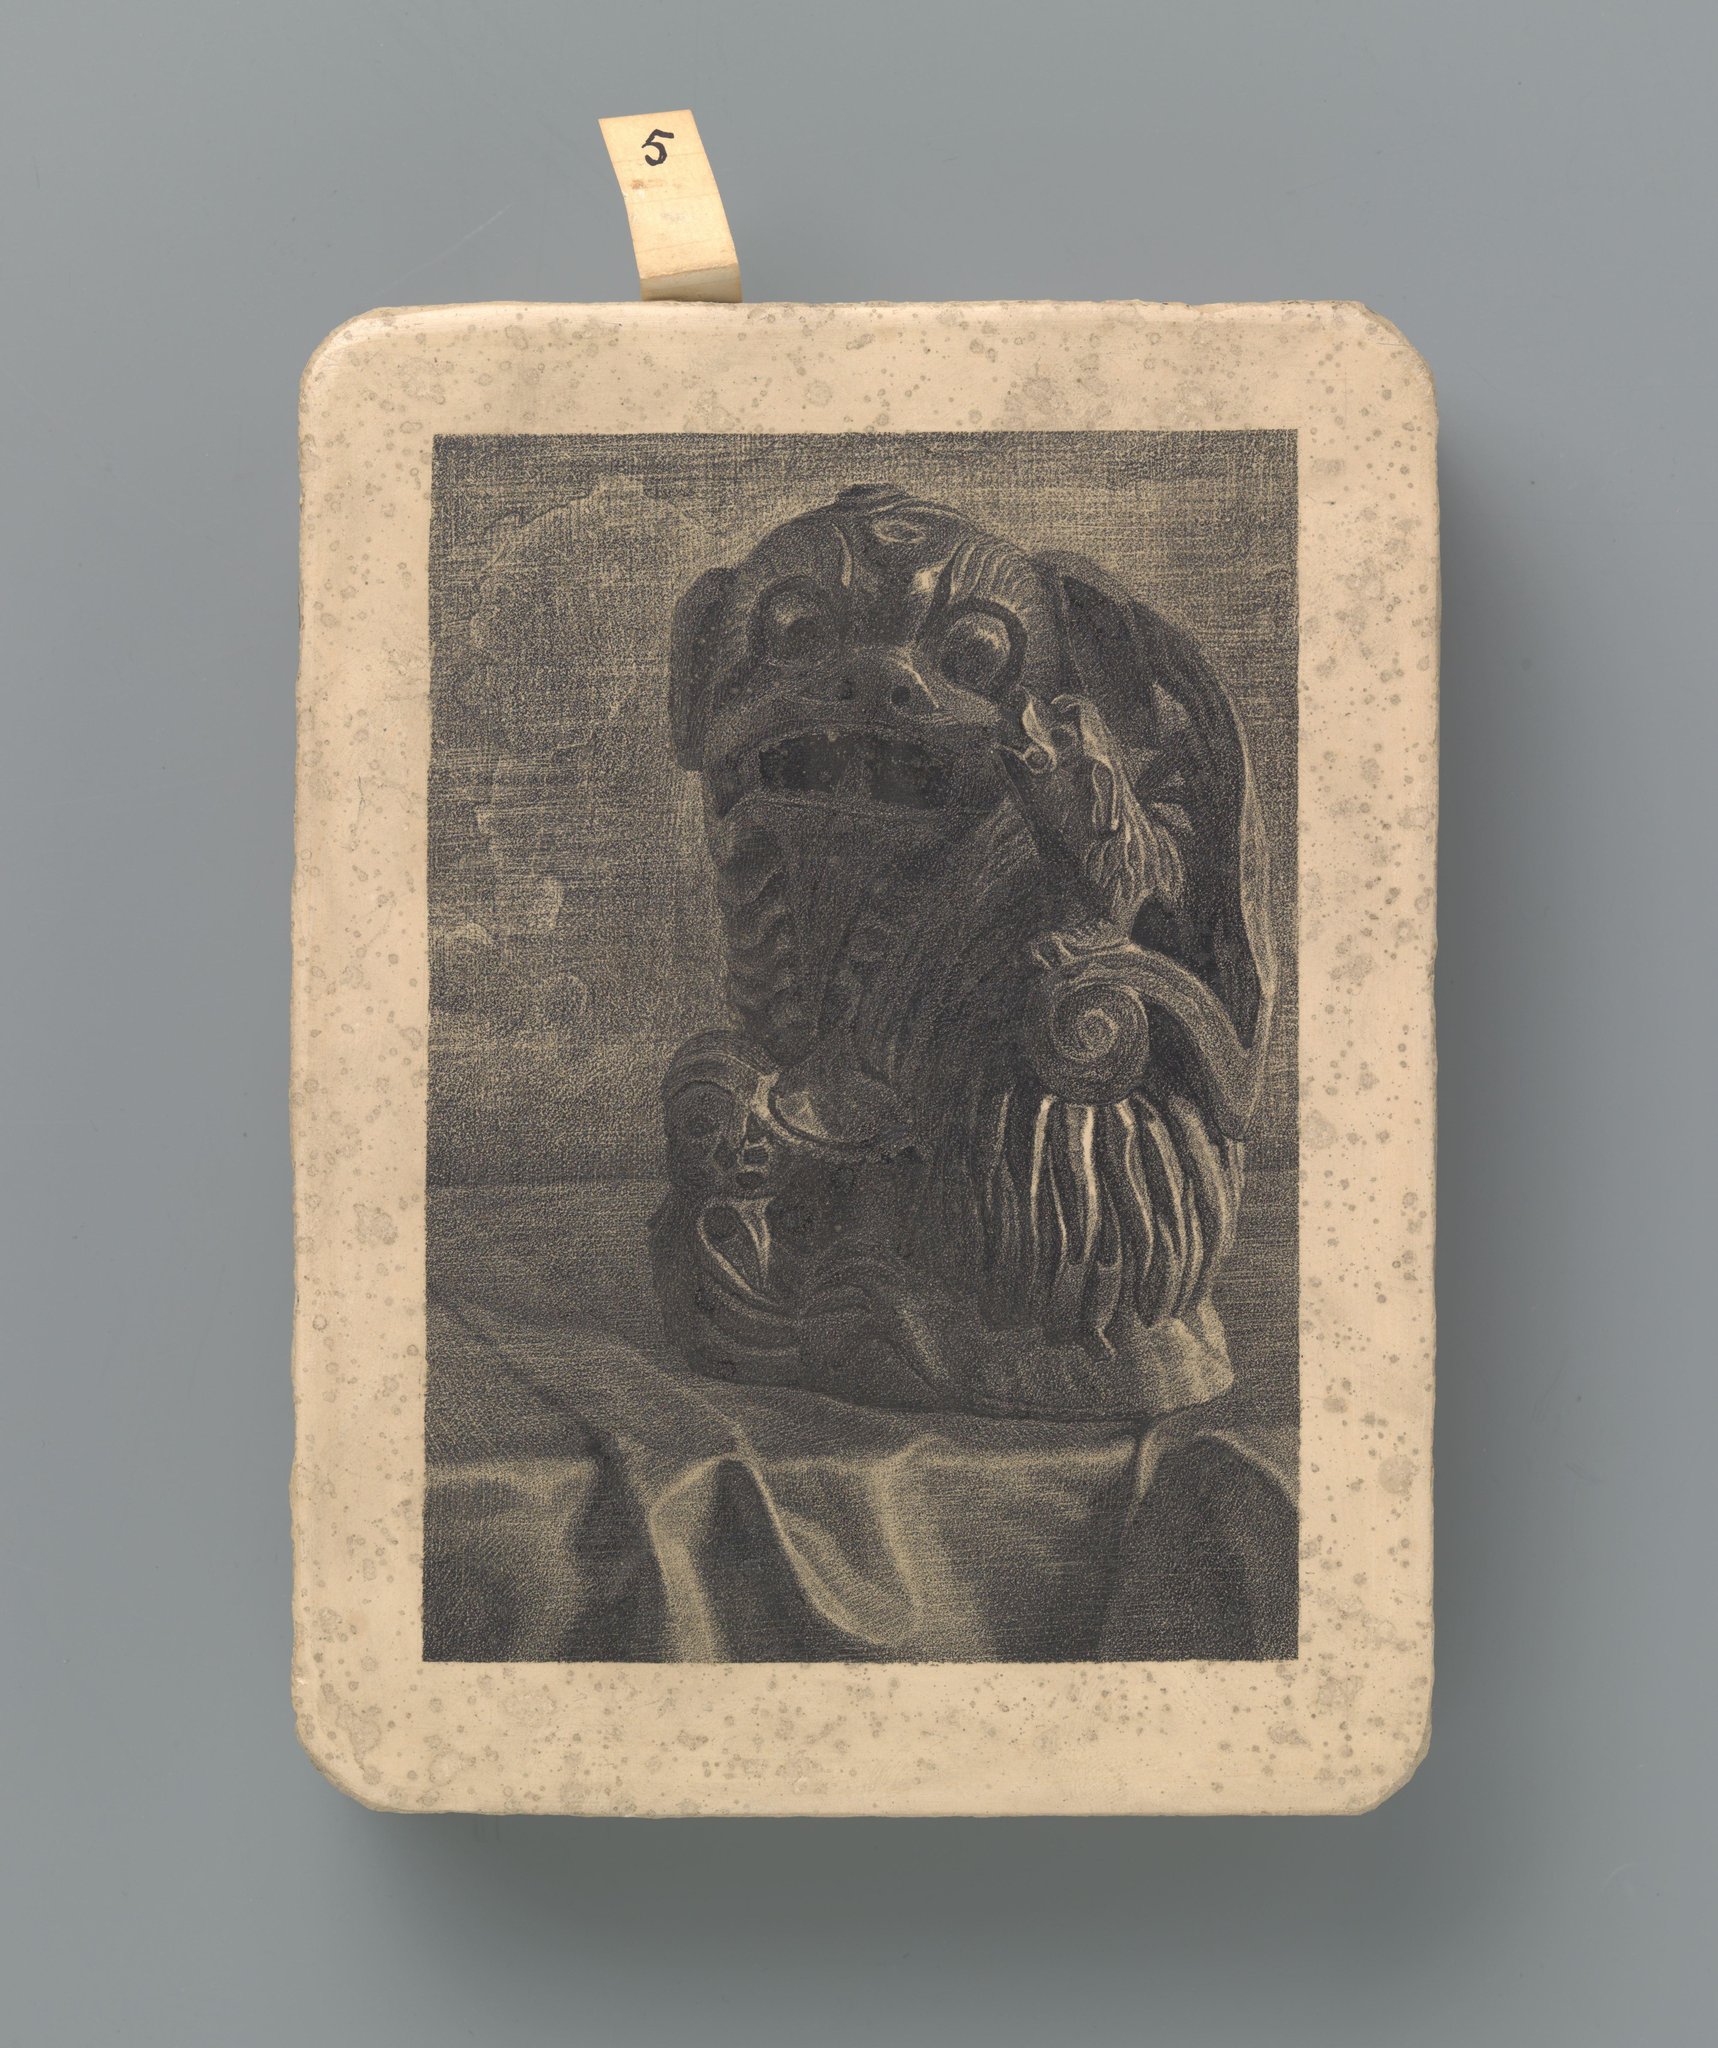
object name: lithographic stone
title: Indonesisch beeldhouwwerk op tafel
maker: julie de graag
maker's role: draughtsman, print maker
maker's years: 1877-1924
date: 1887-1924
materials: stone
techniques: lithograph